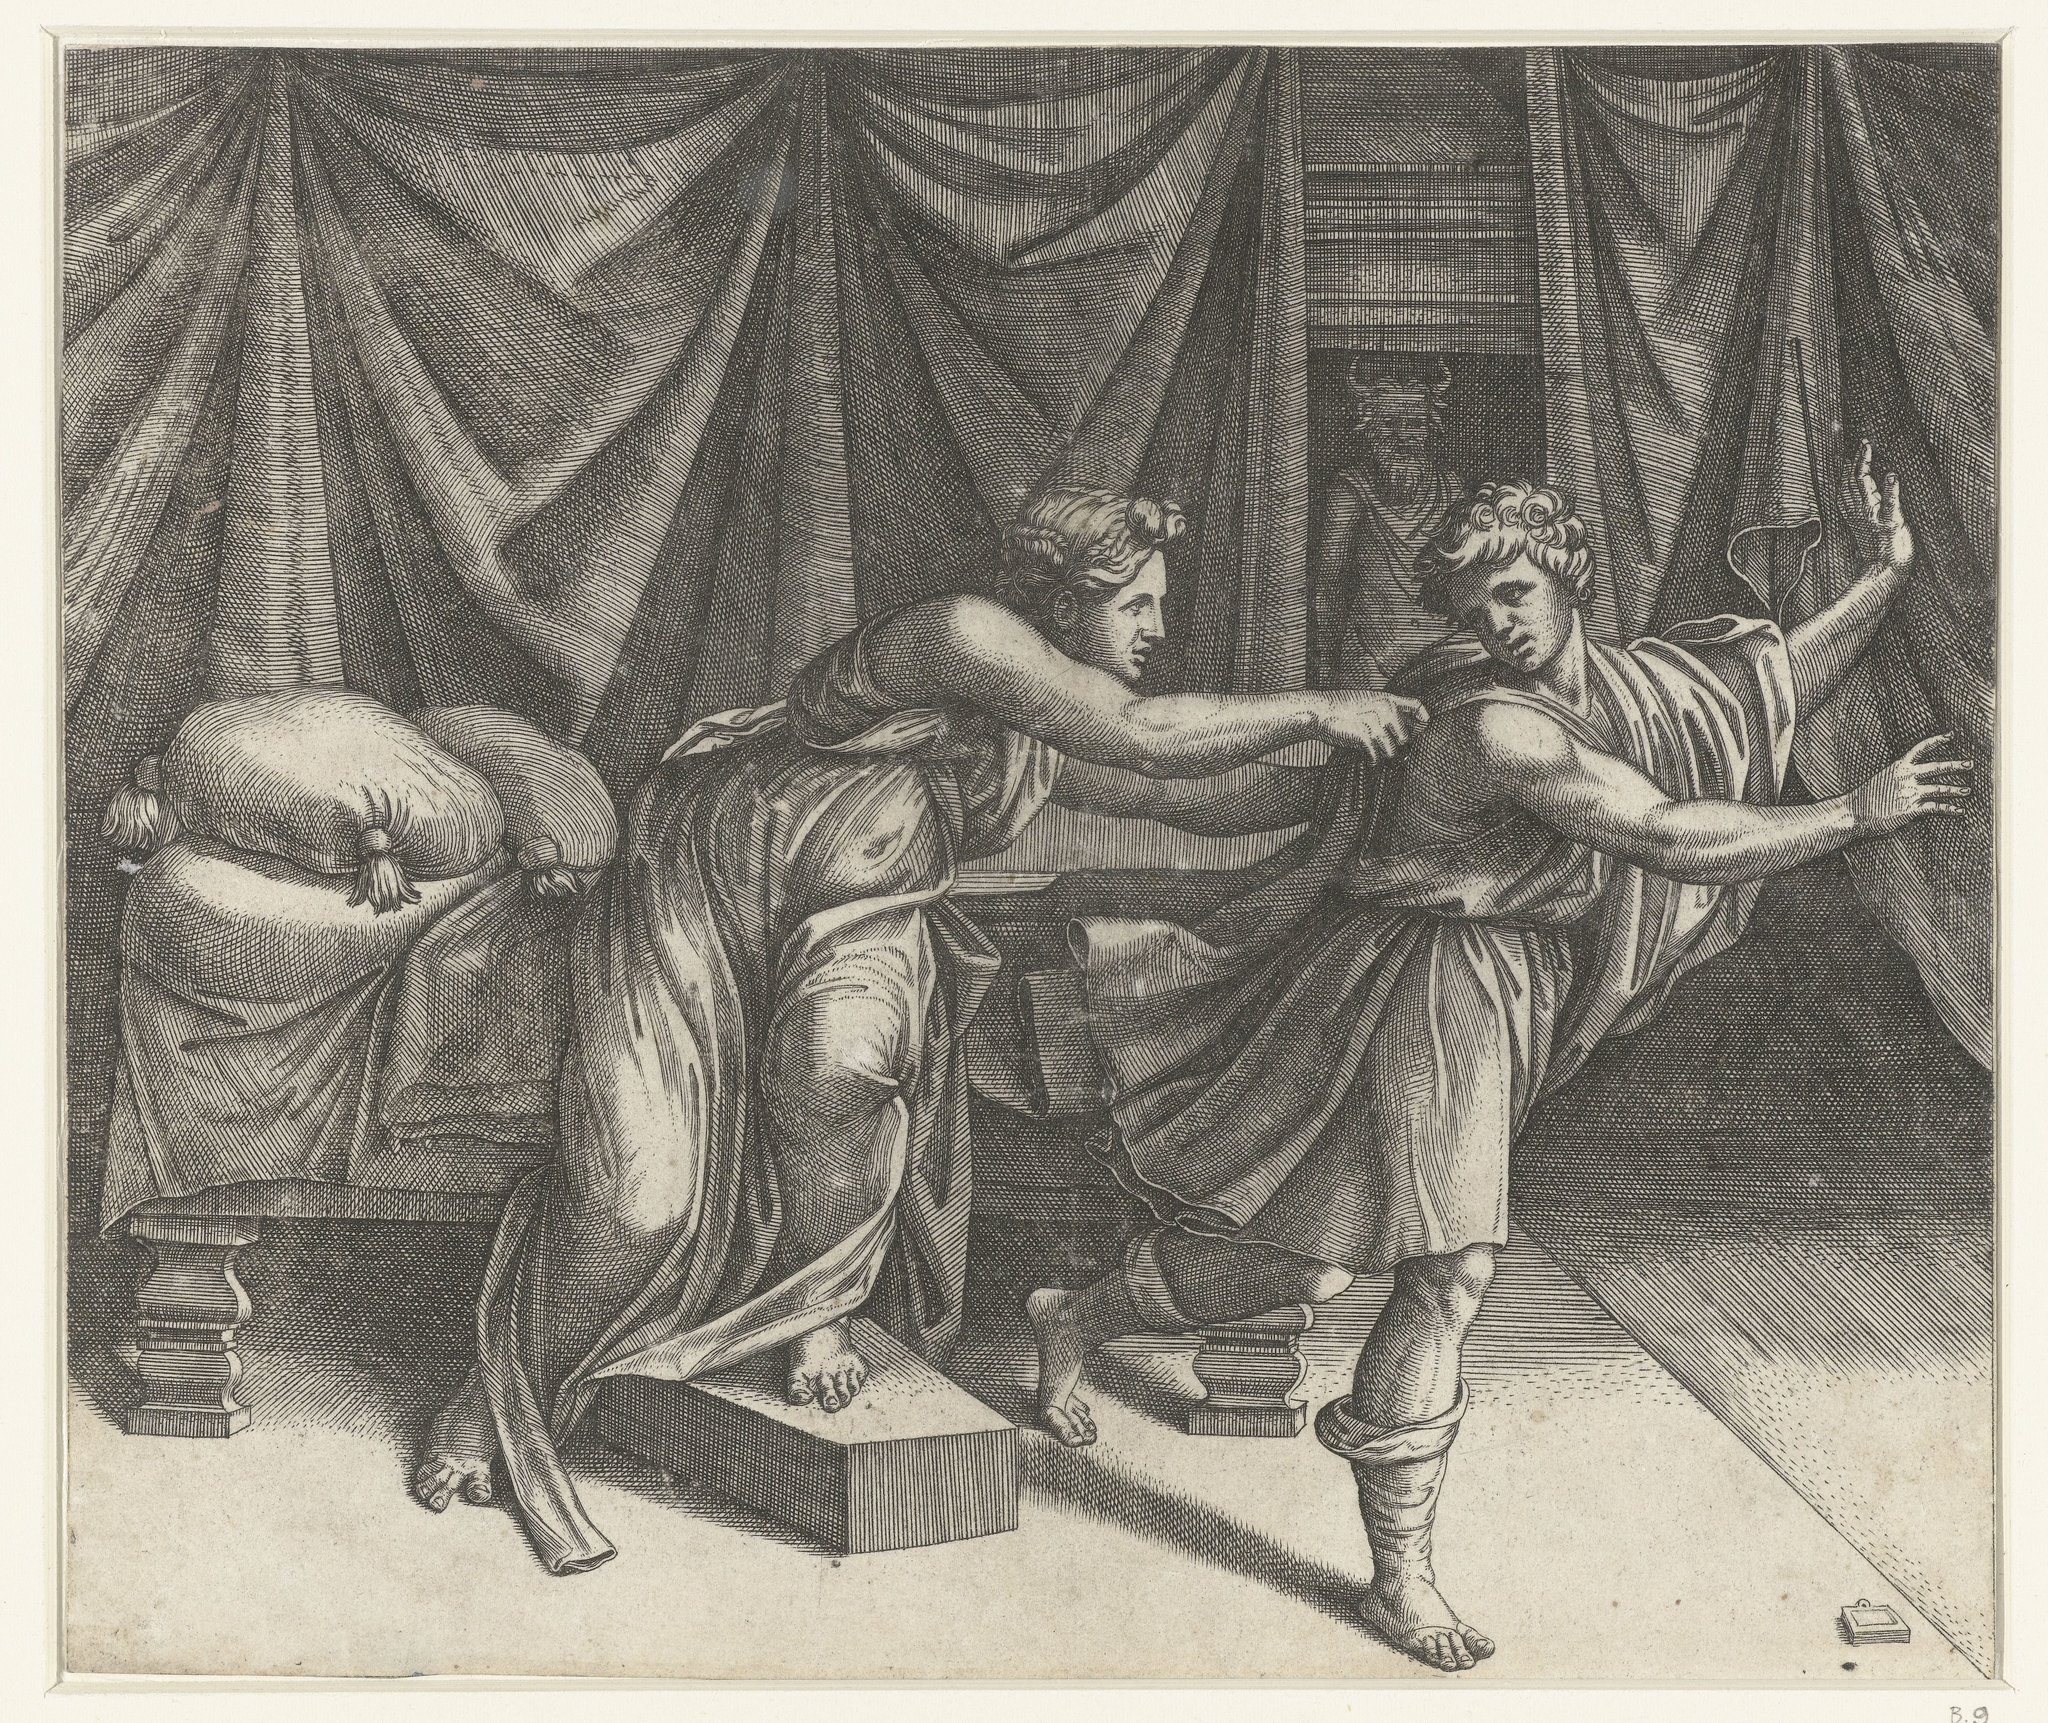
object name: print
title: Jozef en de vrouw van Potifar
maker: marcantonio raimondi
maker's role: print maker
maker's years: 1470-1534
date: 1515-1525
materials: paper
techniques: engraving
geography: italy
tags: potiphar's wife catches joseph by his robe, usually while lying in bed; joseph escapes leaving his cloak behind in her hands (possibly with a naked child lying in a crib)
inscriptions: collector's mark: Lugt 240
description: Prent naar ontwerp van Raphael voor fresco in het Vaticaan.